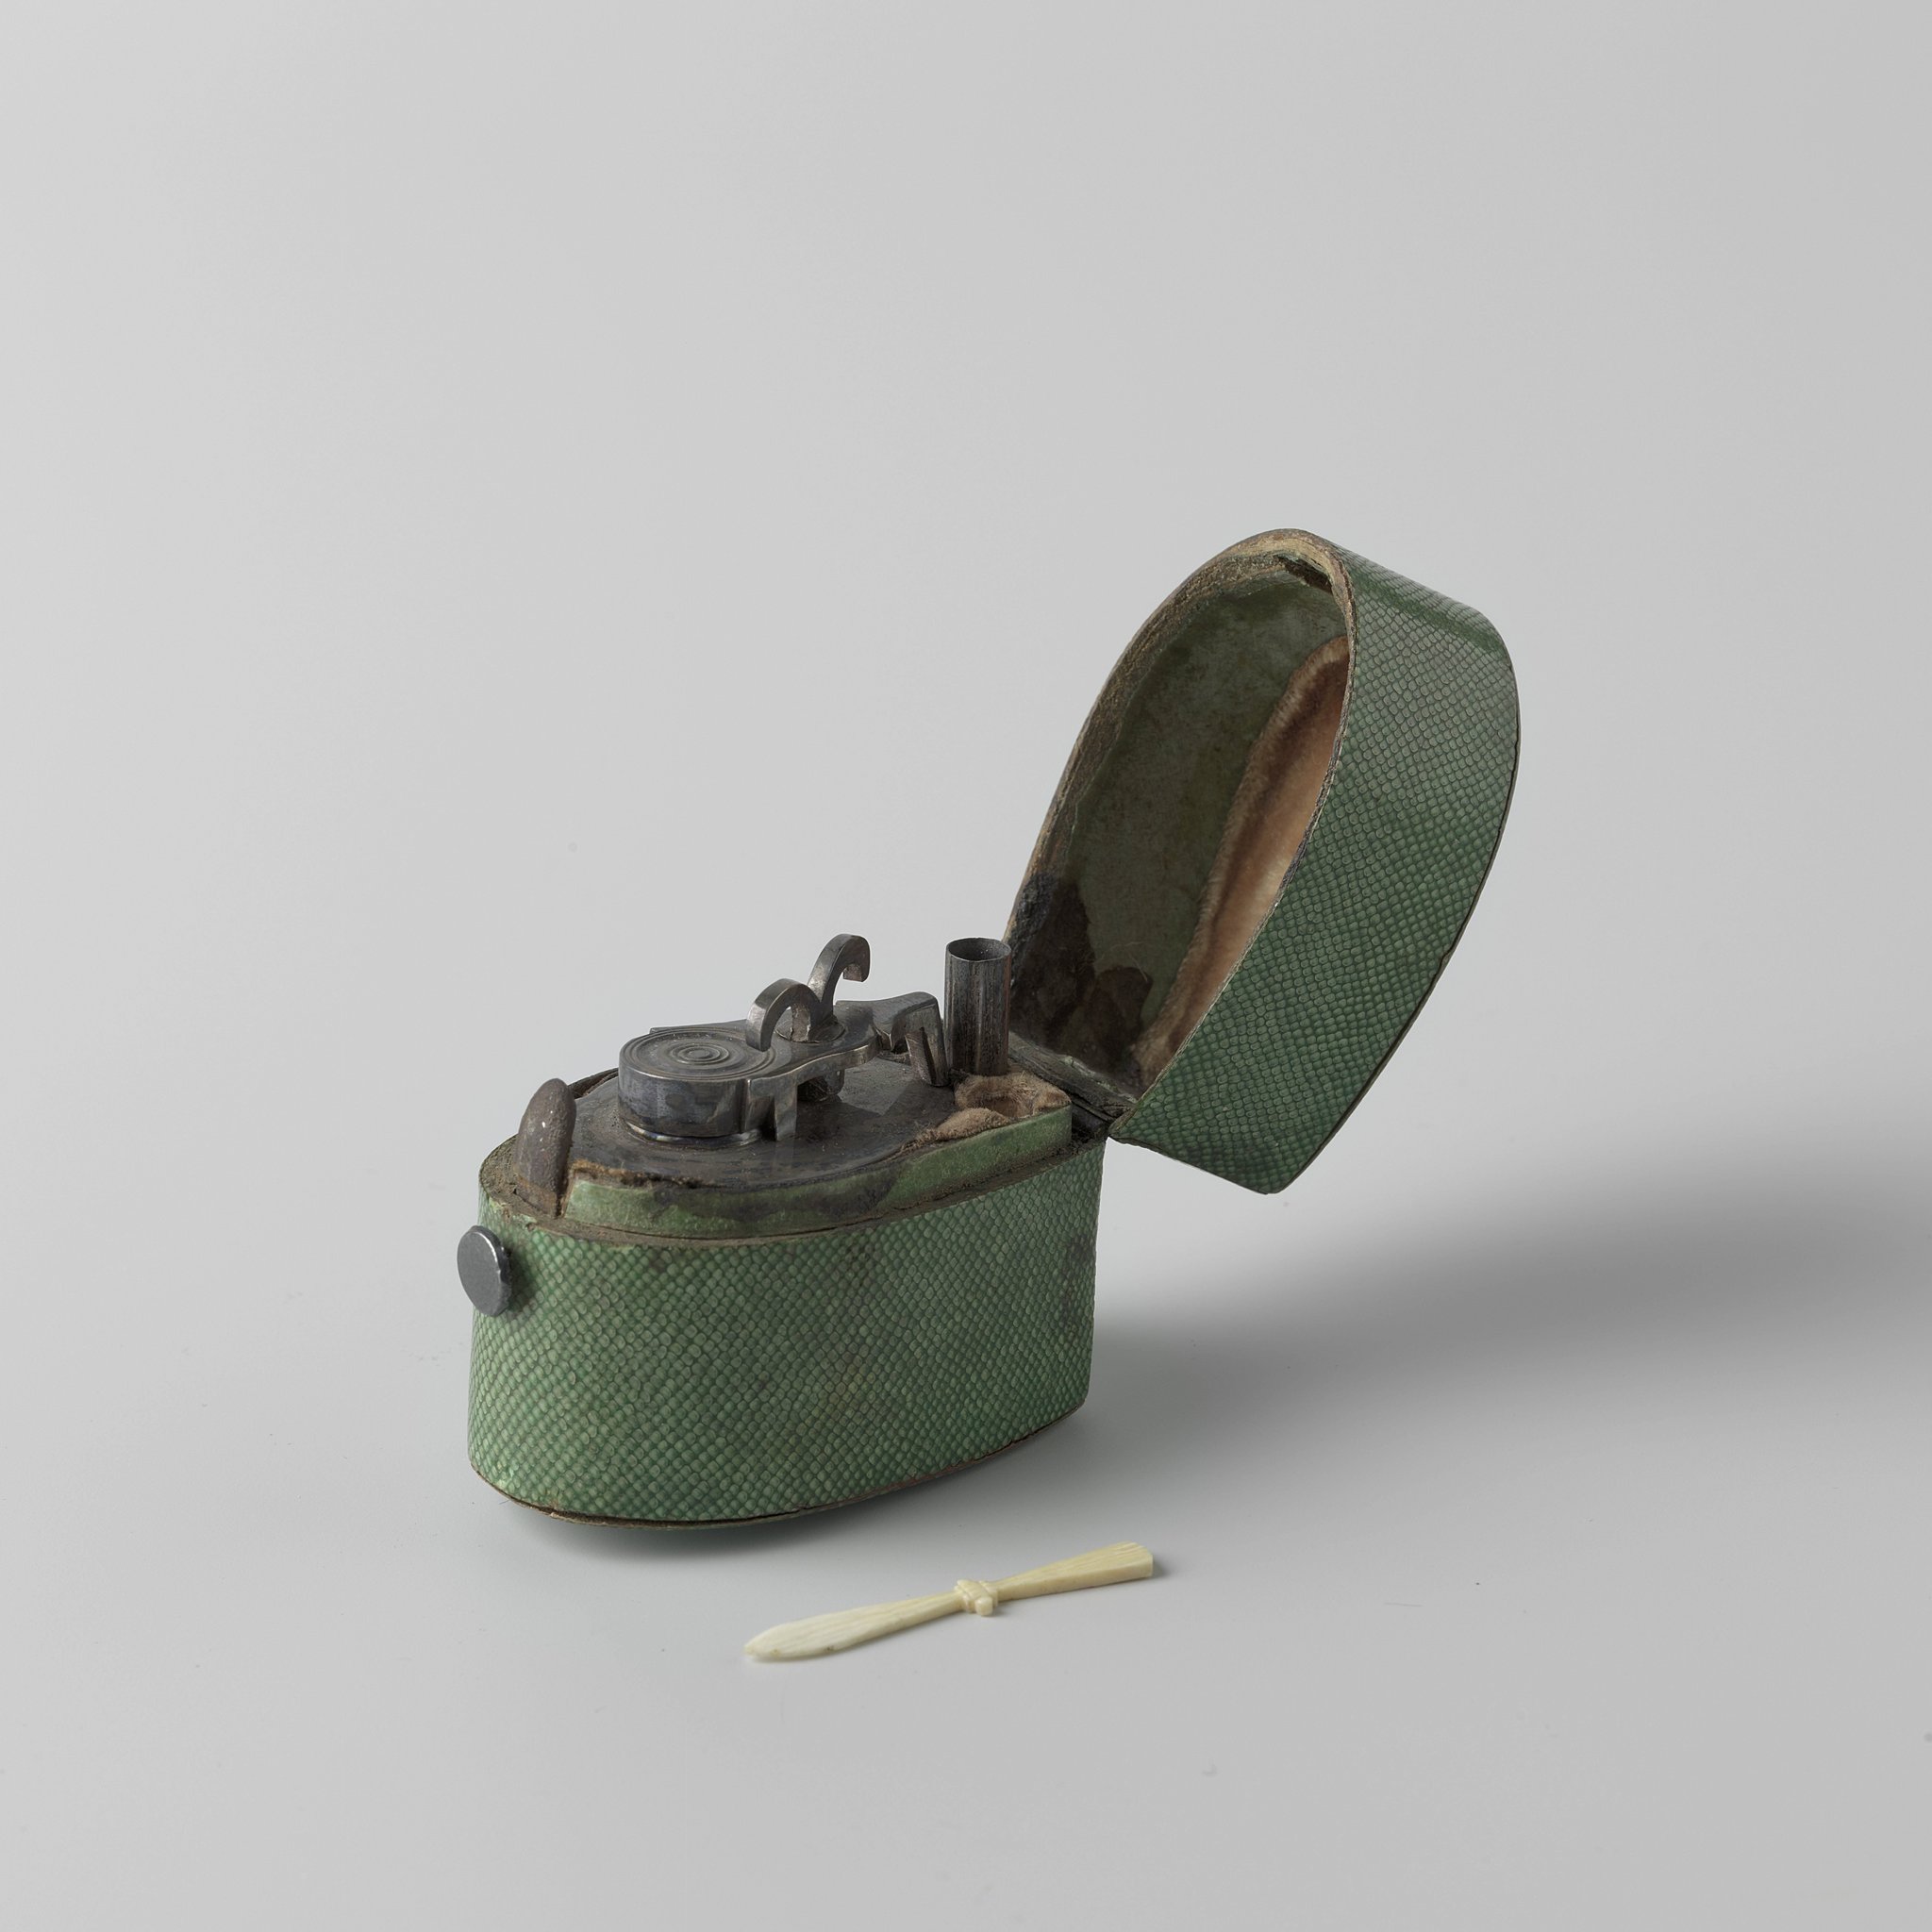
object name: inktkoker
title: Zak-inktkoker van zilver in groen etui van roggevel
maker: eloi brichard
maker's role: silversmith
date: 1761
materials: silver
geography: paris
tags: amsterdam, leiden, lucretia wilhelmina van merken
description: Zak-inktkoker van zilver, in een groen etui van roggevel; gebruikt door de dichteres Lucretia Wilhelmina van Merken (Amsterdam 1721-1789). Parijs, merk: Fermier général Brichard, 1761/2, jaarletter gekroonde X. Geschulpt ovaal van doorsnede.